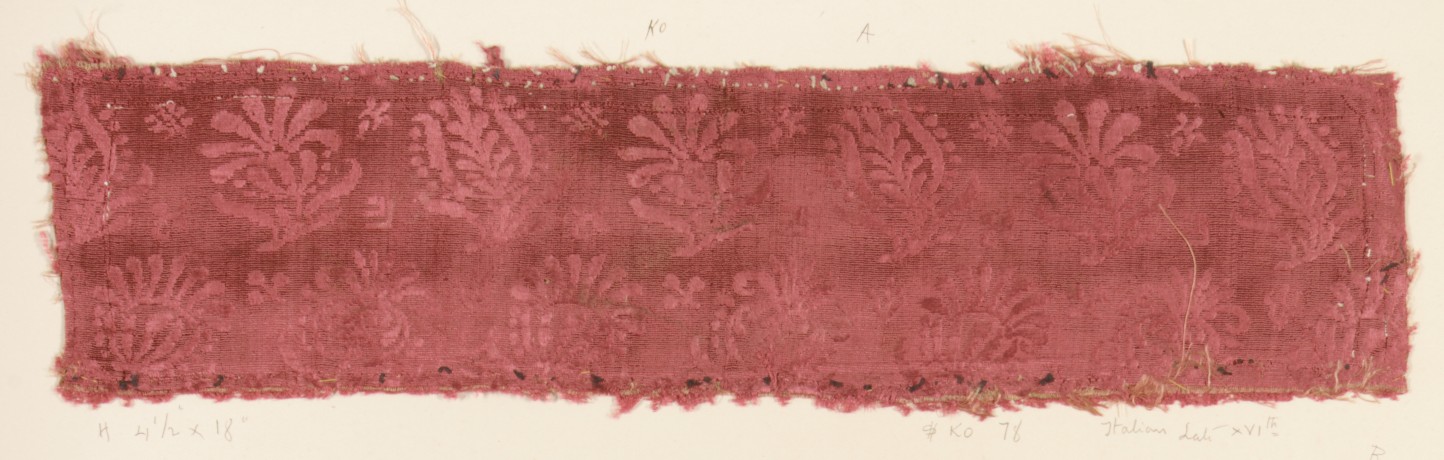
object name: fragment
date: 1567-1600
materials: silk